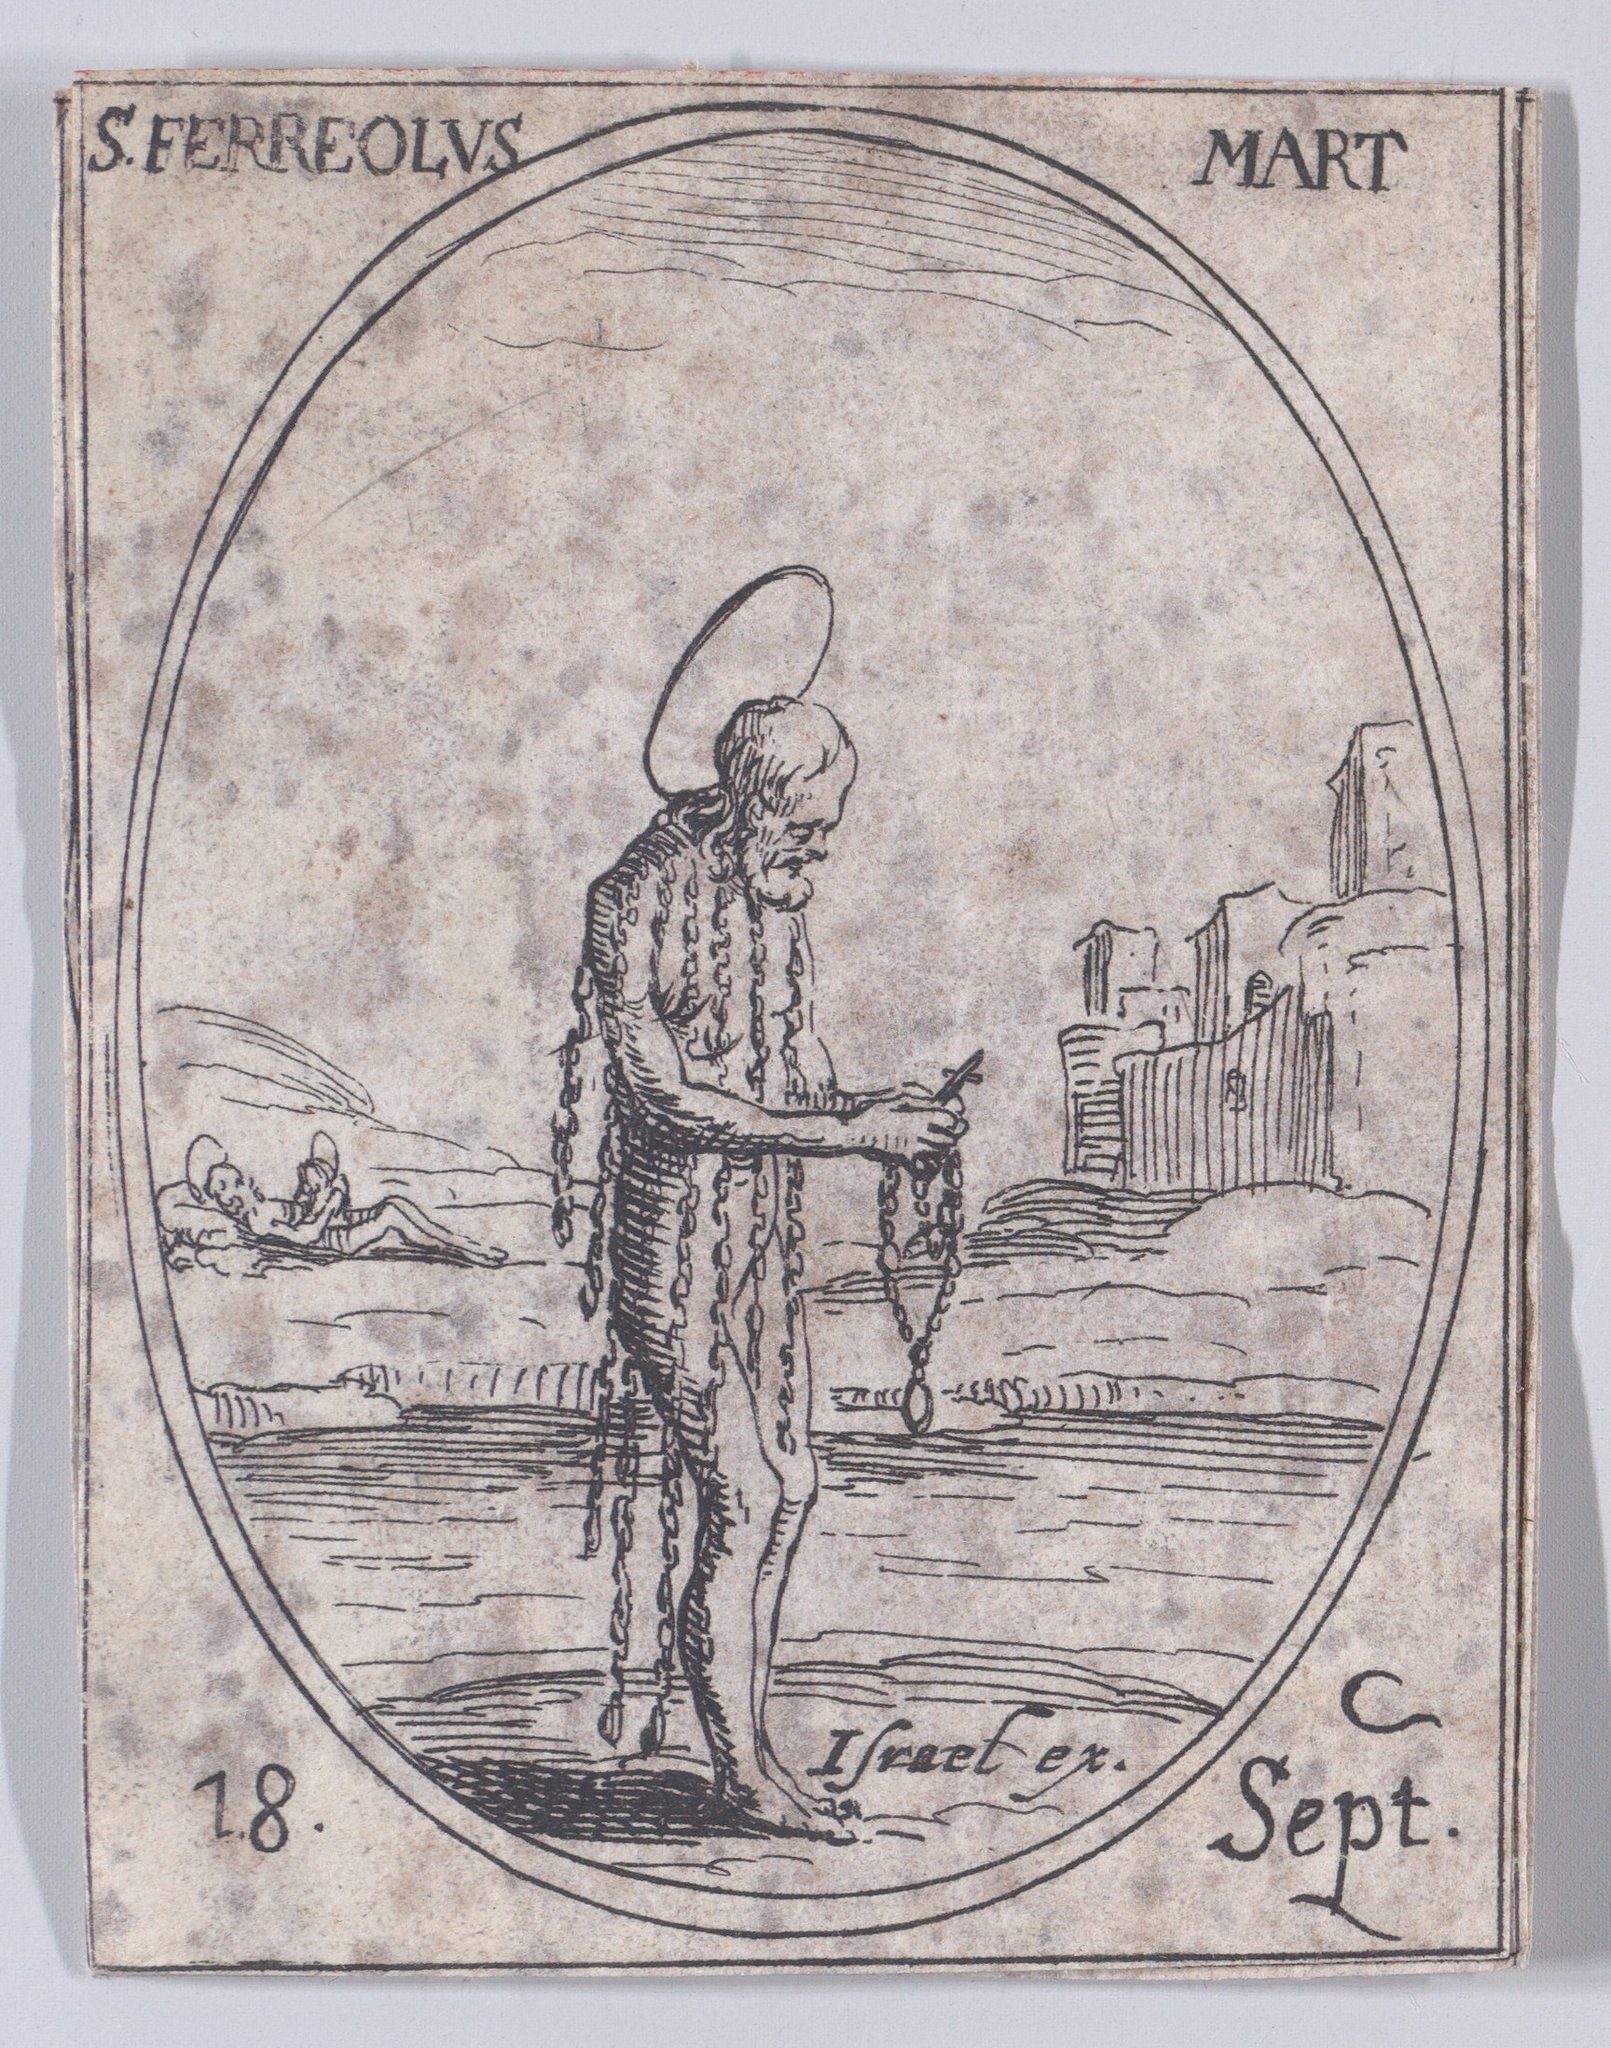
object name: print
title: S. Ferréol, martyr (St. Ferreolus, Martyr), September 18th, from "Les Images De Tous Les Saincts et Saintes de L'Année" (Images of All of the Saints and Religious Events of the Year)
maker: jacques callot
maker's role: artist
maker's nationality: french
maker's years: 1592-1635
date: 1636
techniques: etching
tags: men,saints